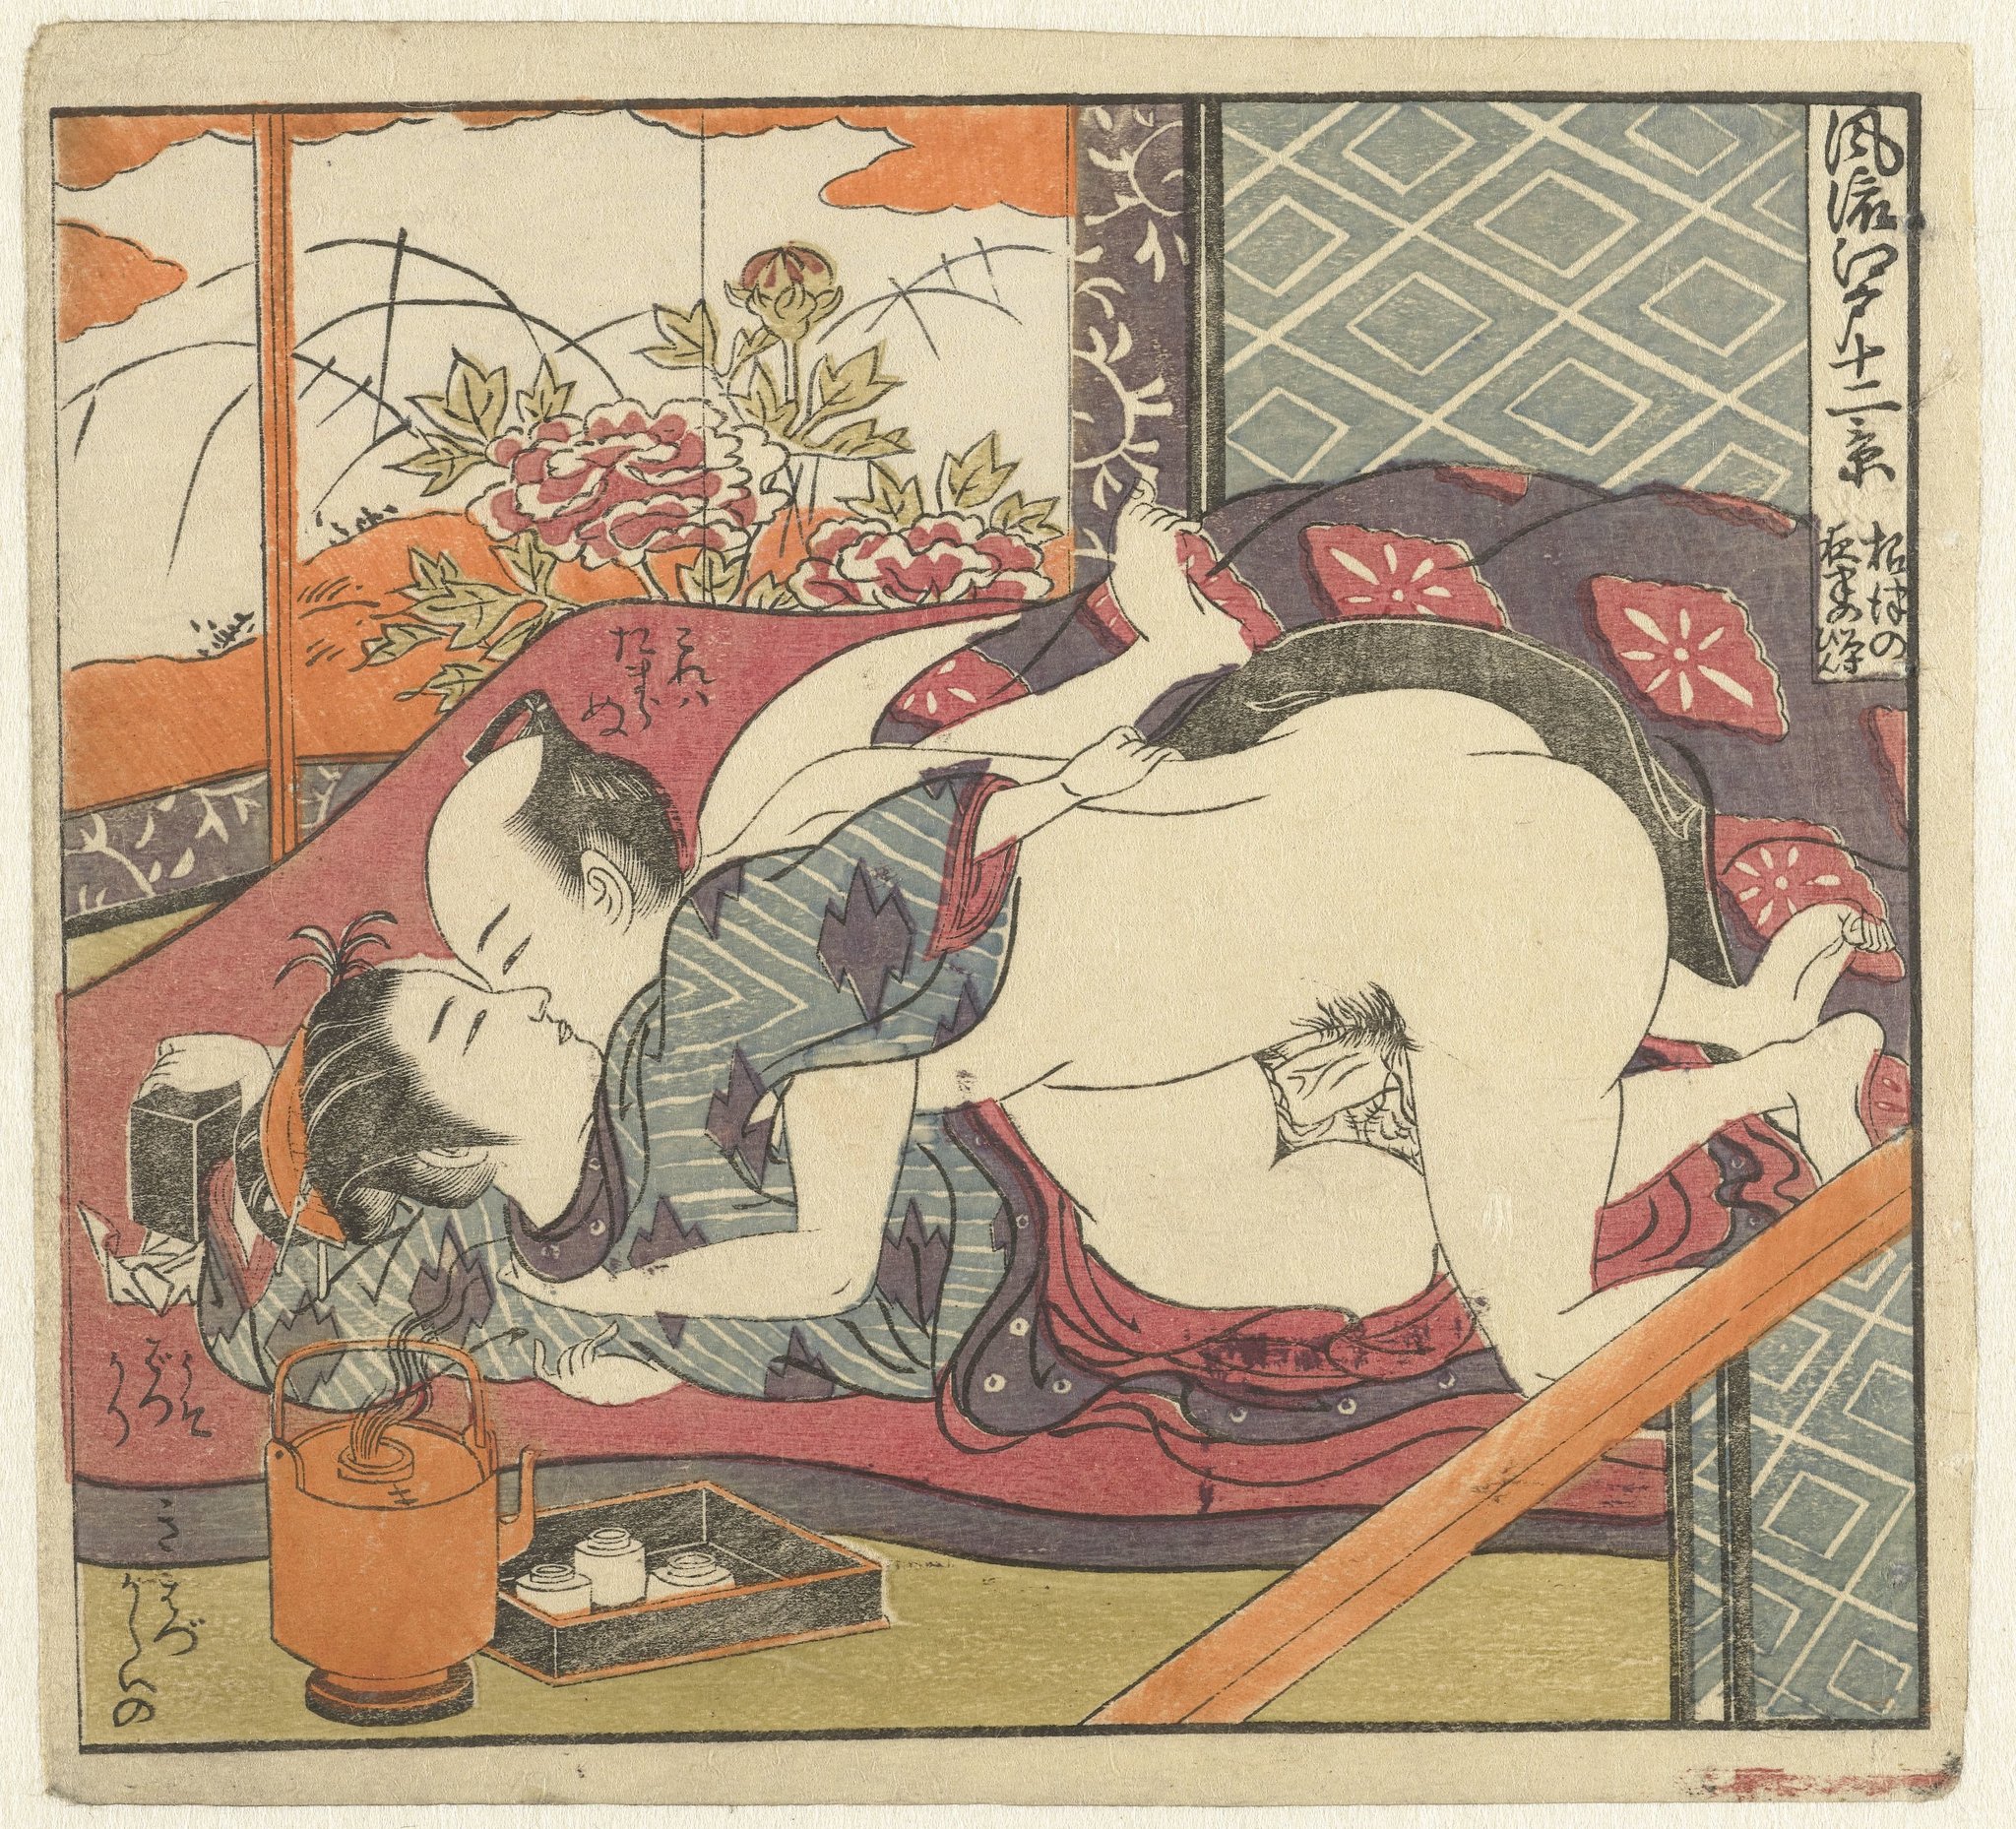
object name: shunga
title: Twaalf gezichten op het verfijnde Edo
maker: isoda kôryûsai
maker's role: print maker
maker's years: 1735-1790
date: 1770-1775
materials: paper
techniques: woodcut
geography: japan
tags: coitus, cohabiting, sexual intercourse